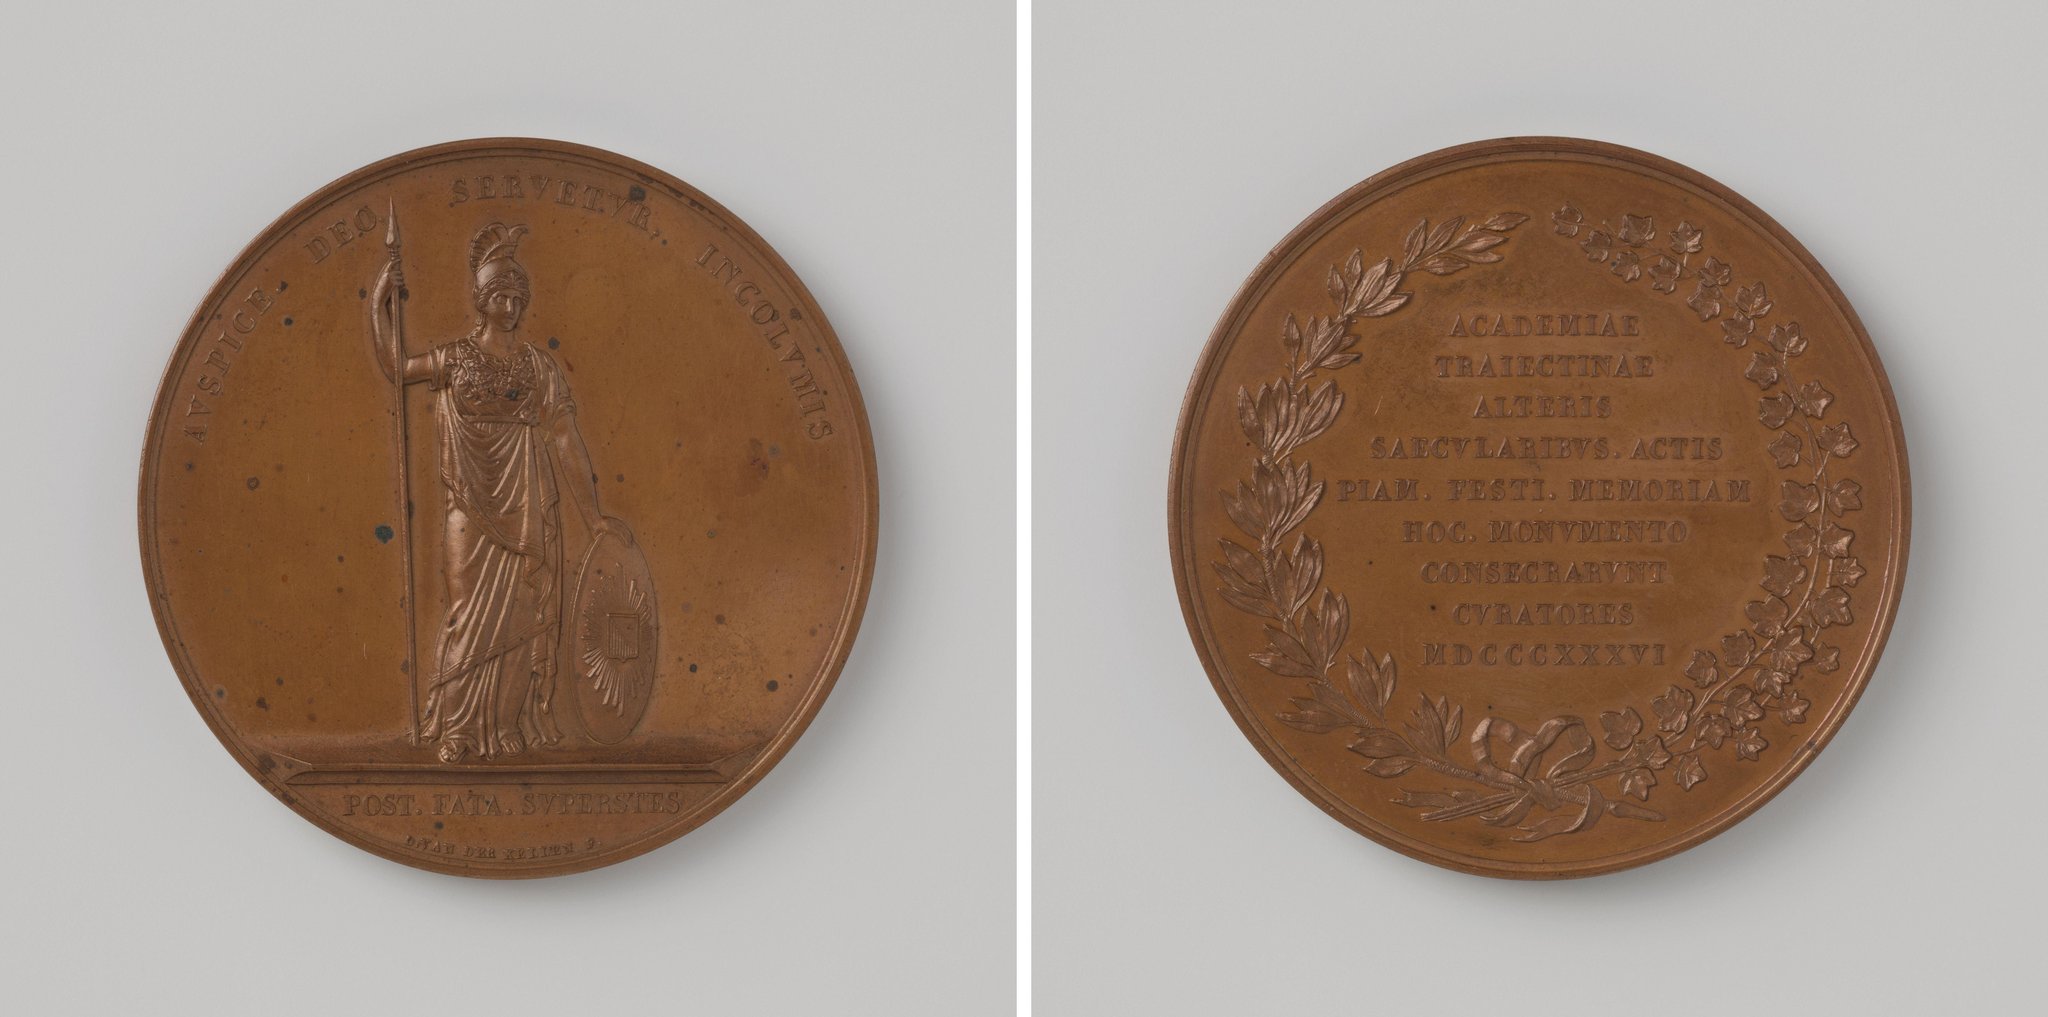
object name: history medal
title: Tweehonderdjarig bestaan van de Universiteit te Utrecht 1836 (curatorenpenning)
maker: david van der kellen (1804-1879)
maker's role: die cutter, draughtsman, print maker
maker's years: 1804-1879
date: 1835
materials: bronze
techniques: striking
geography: utrecht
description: Bronzen penning, op de voorzijde Minerva met speer en schild waarop het wapen van de Utrechtse akademie, met omschrift en afsnedetekst, op de keerzijde negen regsl tekst tussen een samengestrikte lauwer- en klimoptak.